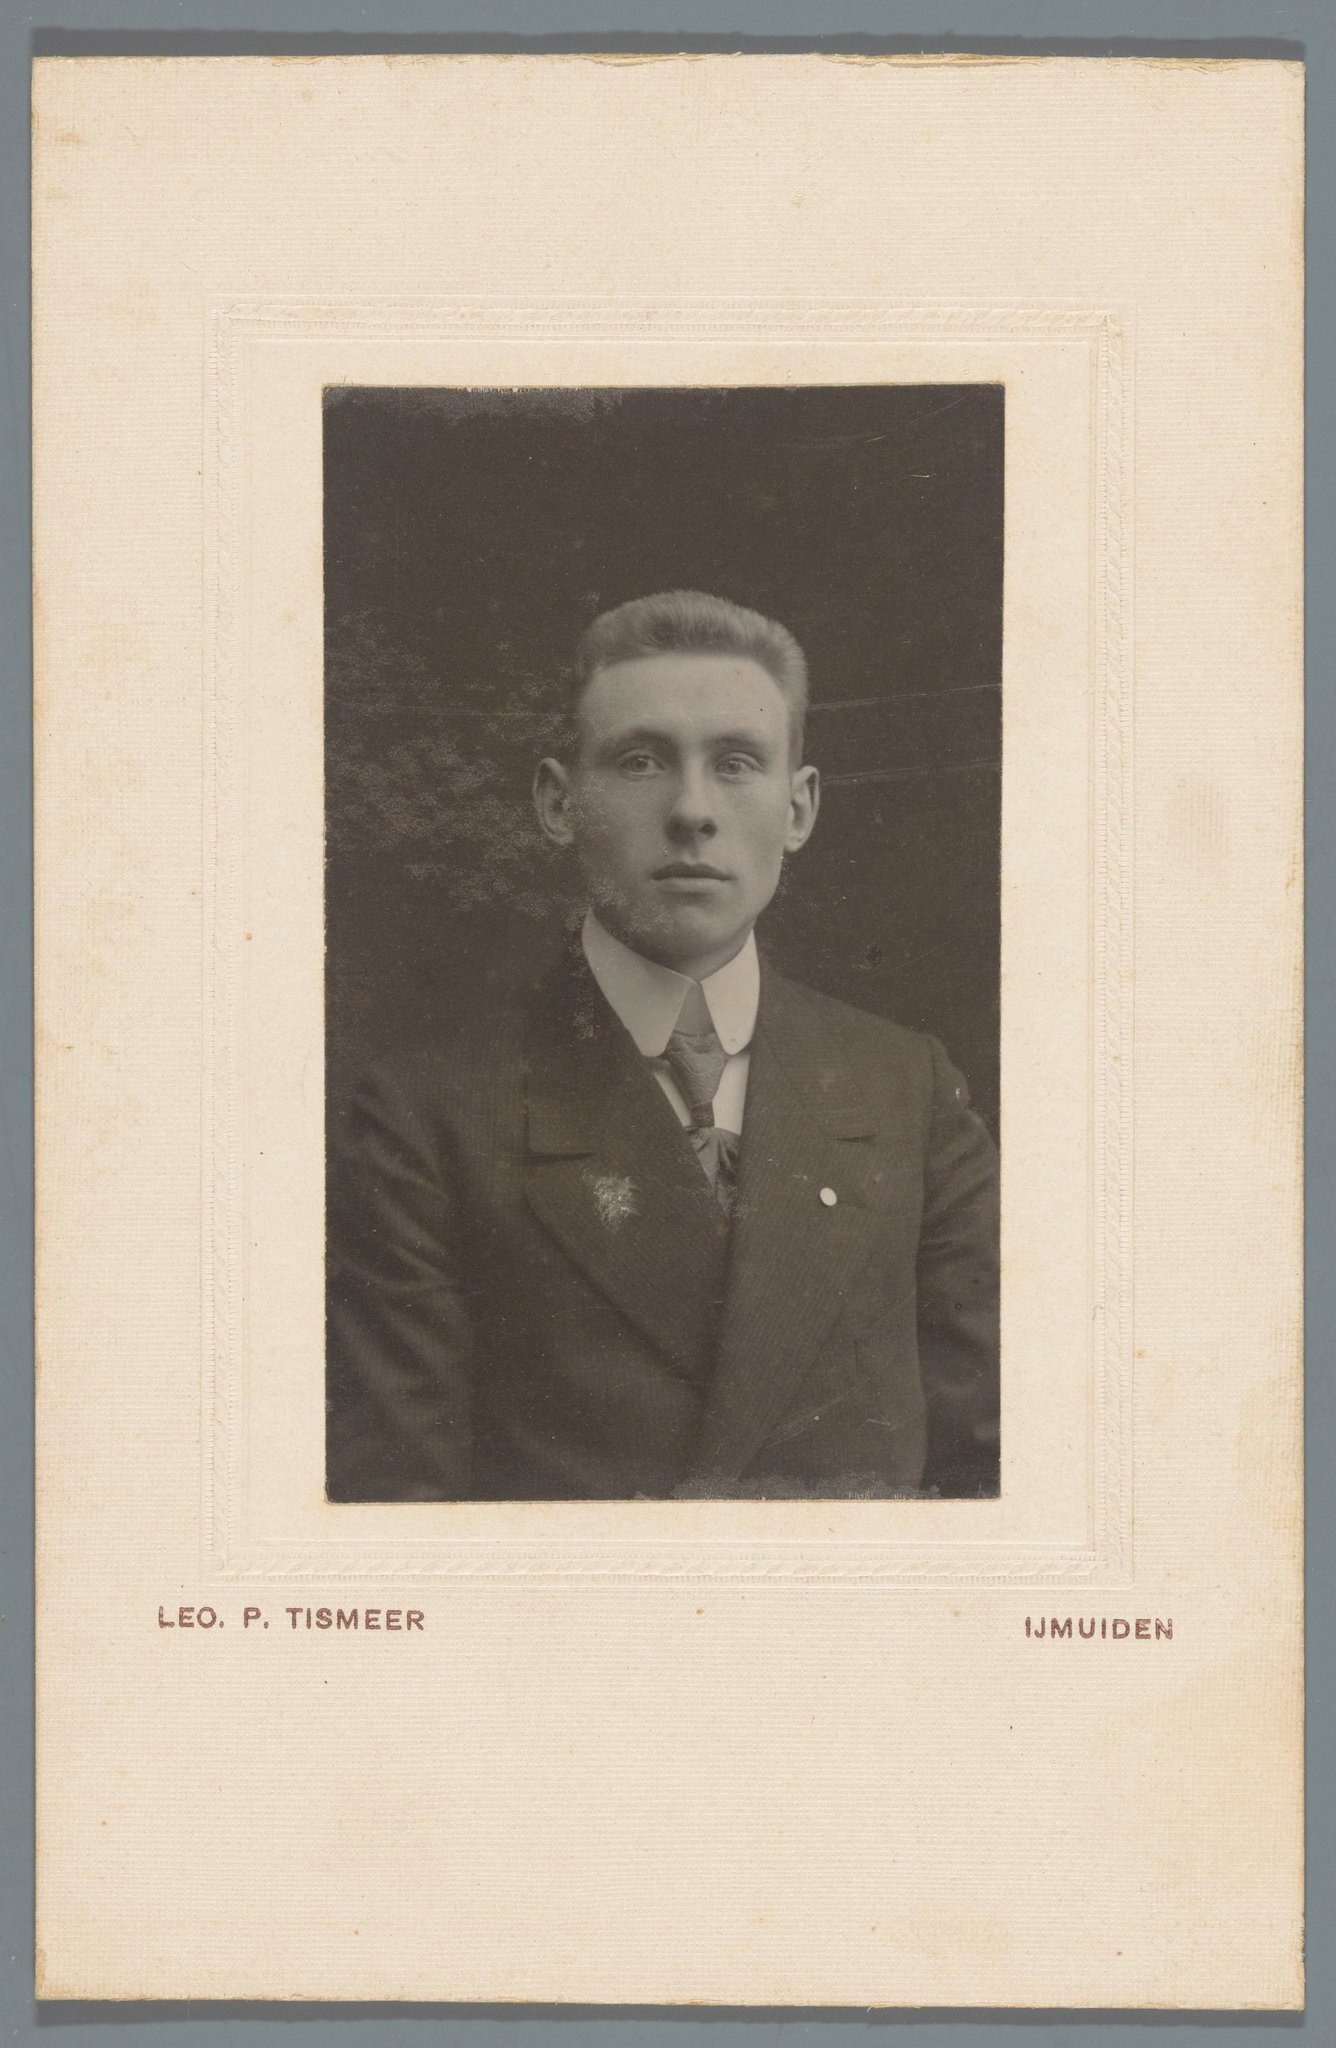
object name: photograph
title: Portret van een onbekende man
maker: leonardus pieter tismeer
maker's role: fotograaf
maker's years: 1874-1961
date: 1910-1920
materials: cardboard, photographic support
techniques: gelatin silver print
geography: ijmuiden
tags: adult man